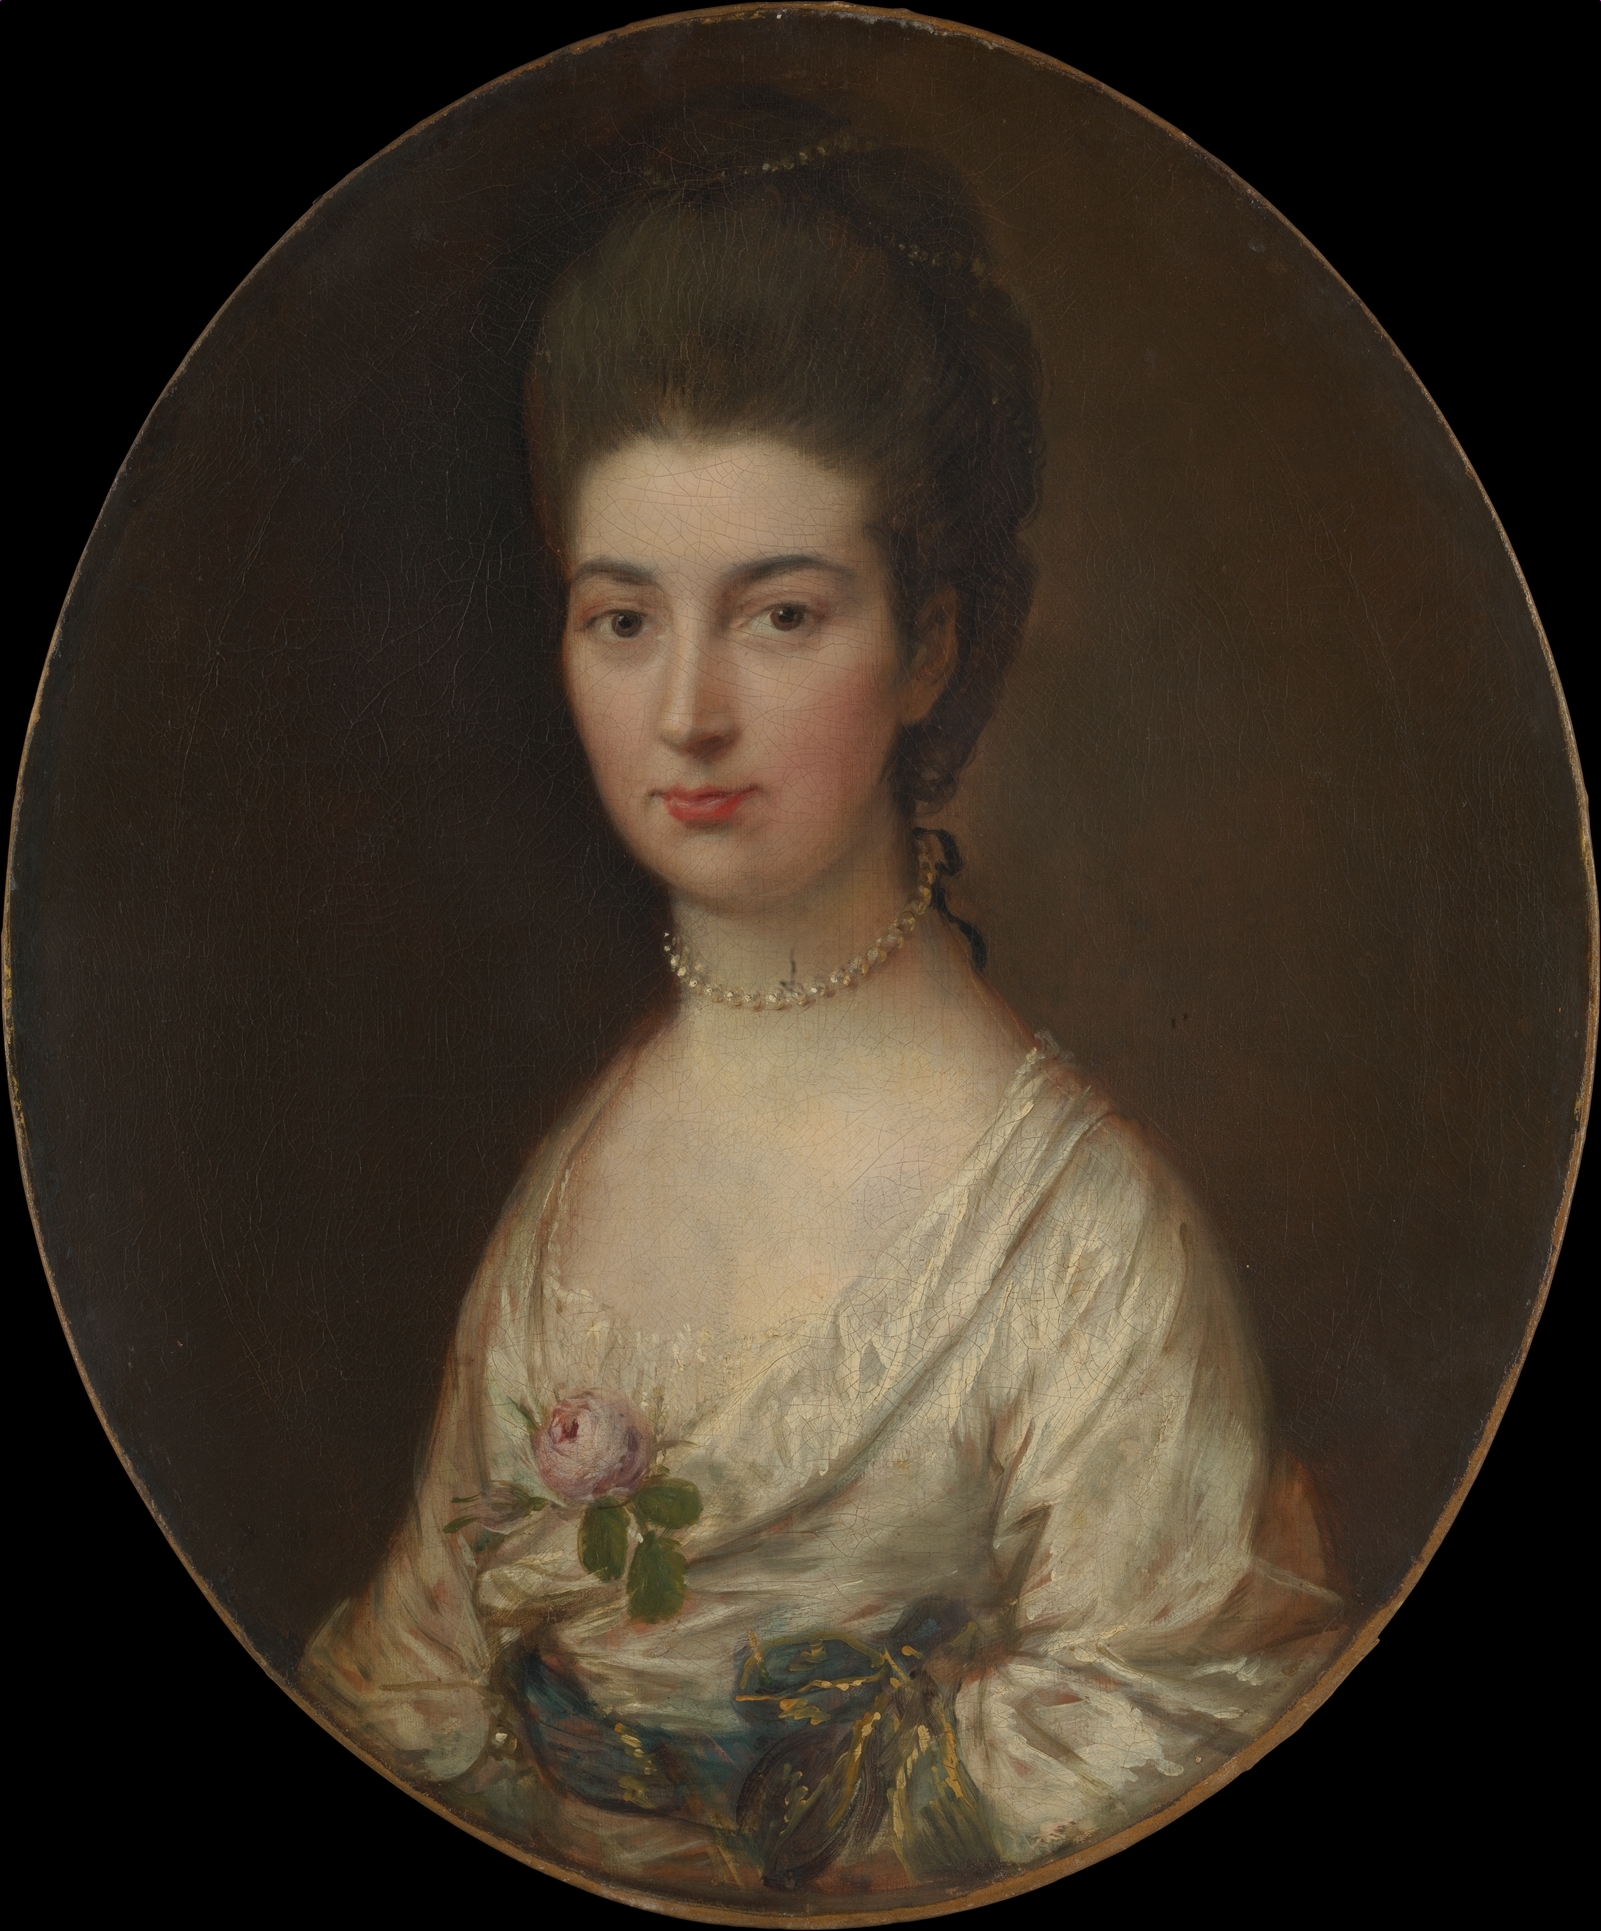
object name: painting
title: Mrs. Ralph Izard (Alice De Lancey, 1746/47–1832)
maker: thomas gainsborough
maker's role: artist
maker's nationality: british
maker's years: 1727-1788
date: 1747-1788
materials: canvas, oil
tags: portraits,women